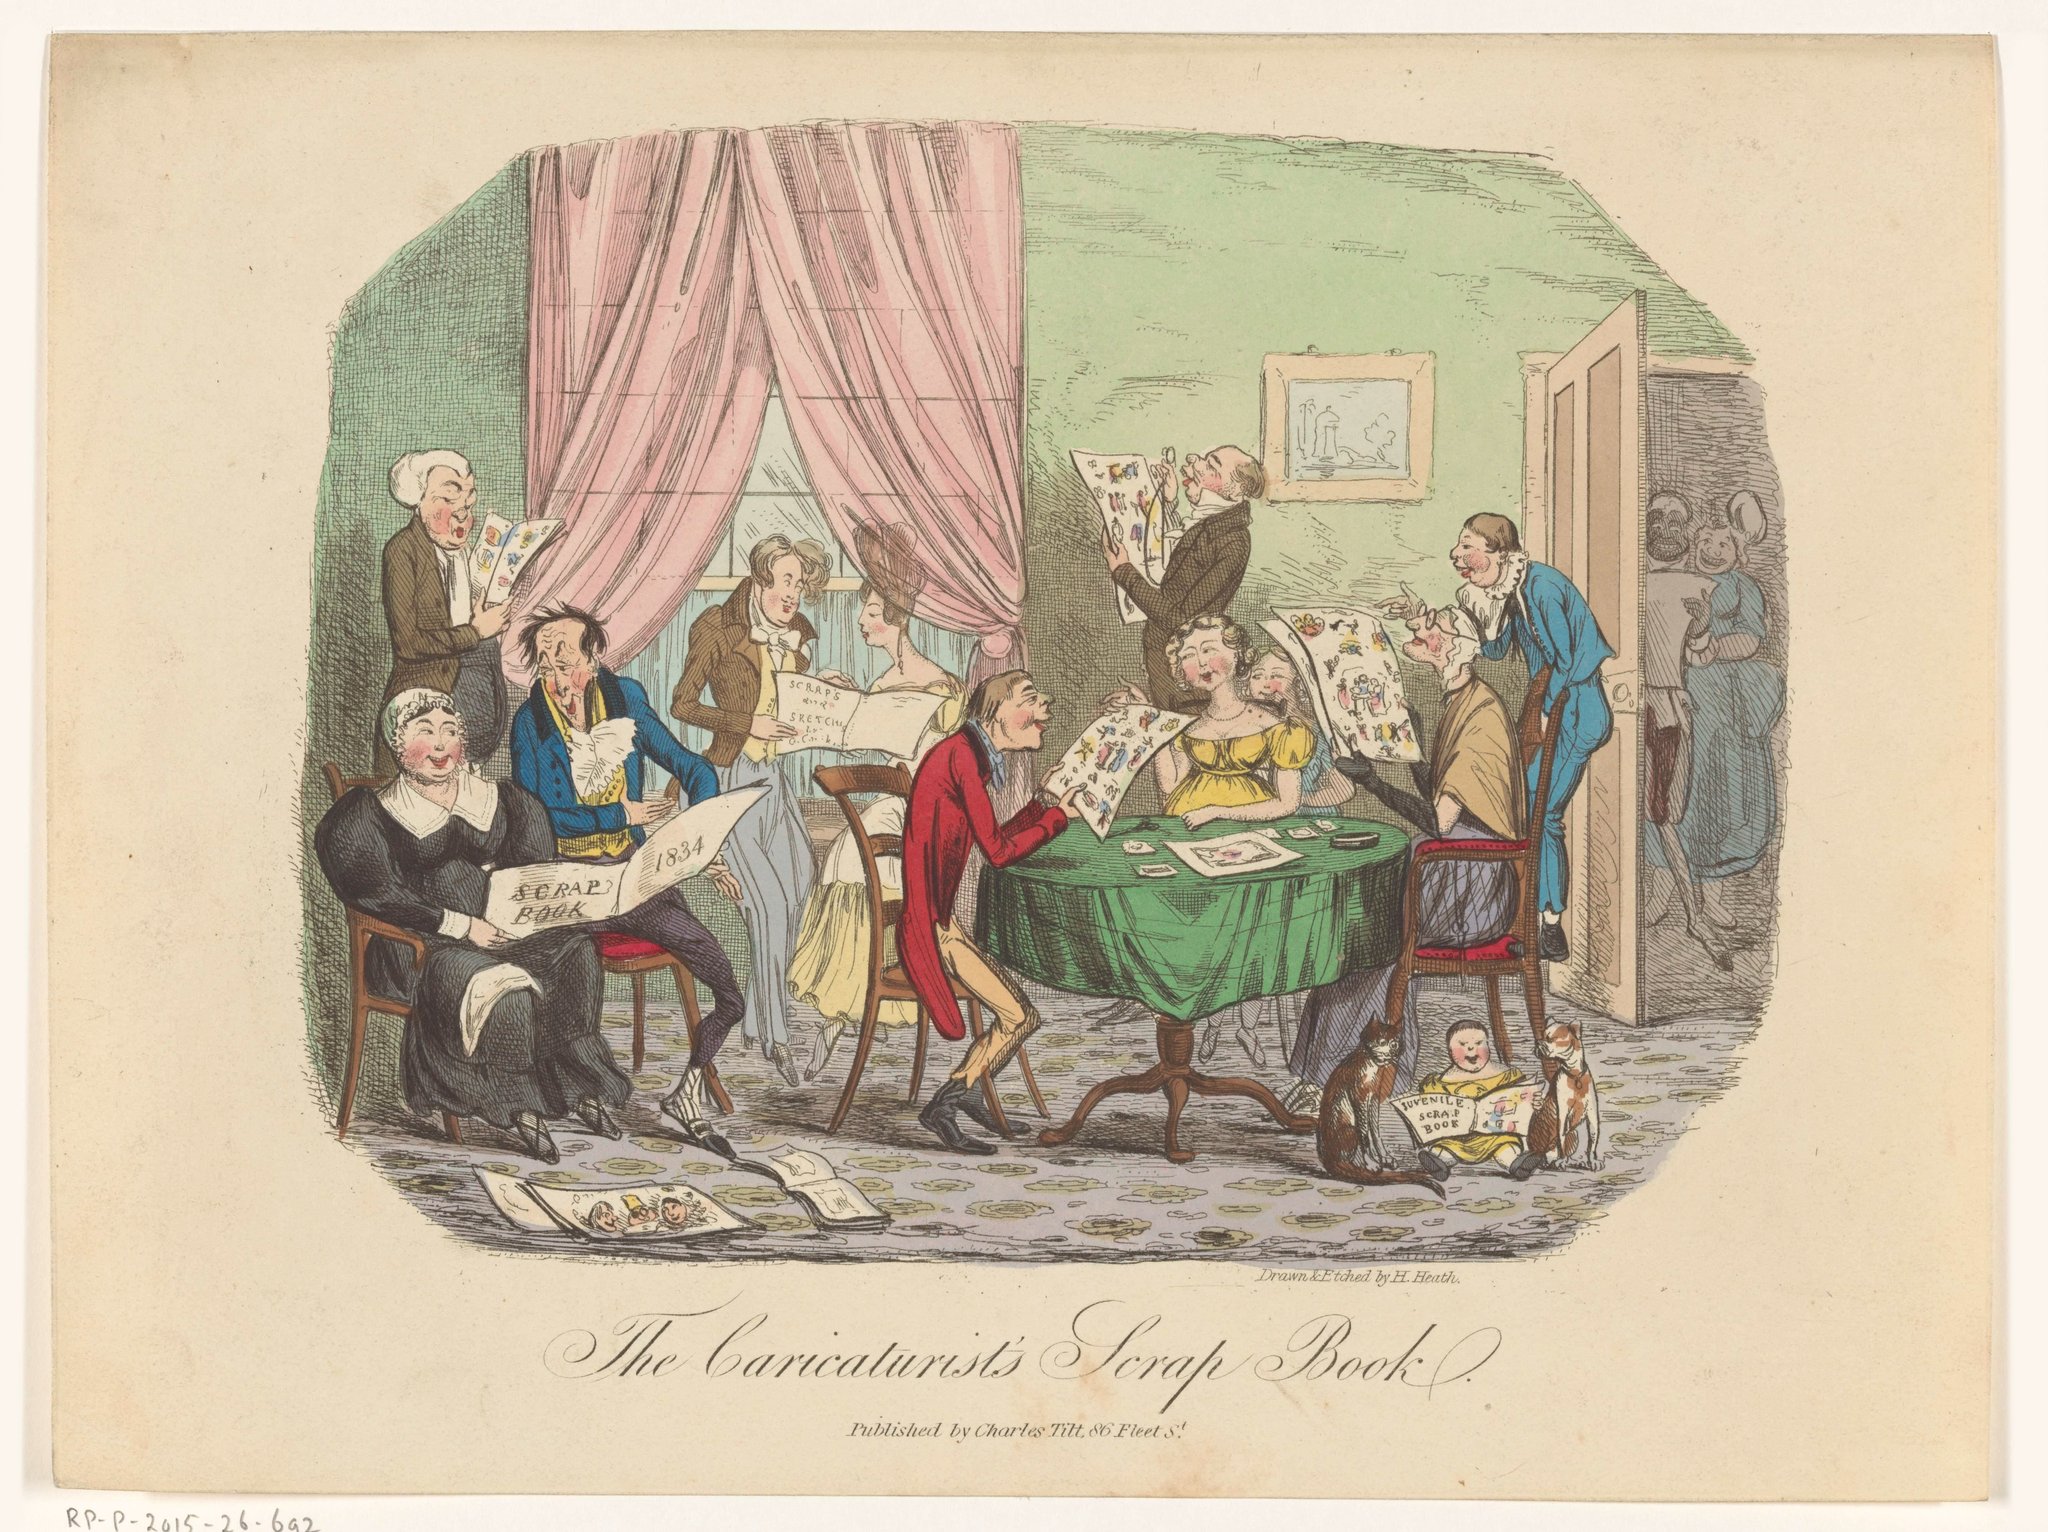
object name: print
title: Interieur met mensen die bladen uit The Caricaturist's Scrap Book bekijken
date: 1834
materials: paper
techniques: etching, hand coloring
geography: london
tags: caricatures (human types), print, e.g.: engraving, etching, lithograph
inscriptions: collector's mark: Lugt 2228, collector's mark: Lugt 4779